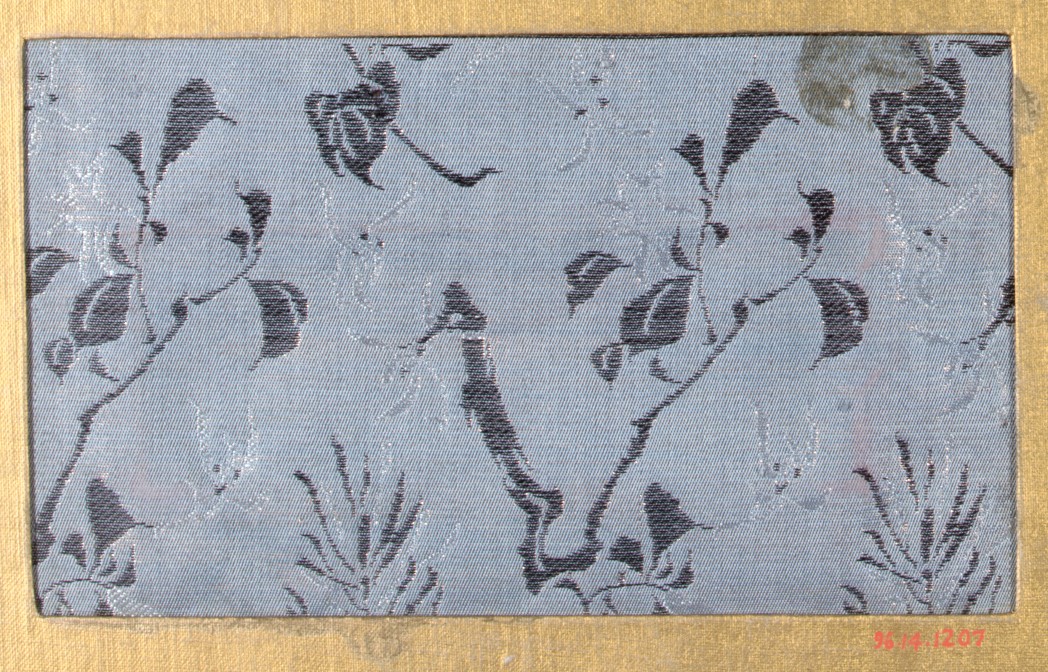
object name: piece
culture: japanese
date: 1701-1900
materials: silk